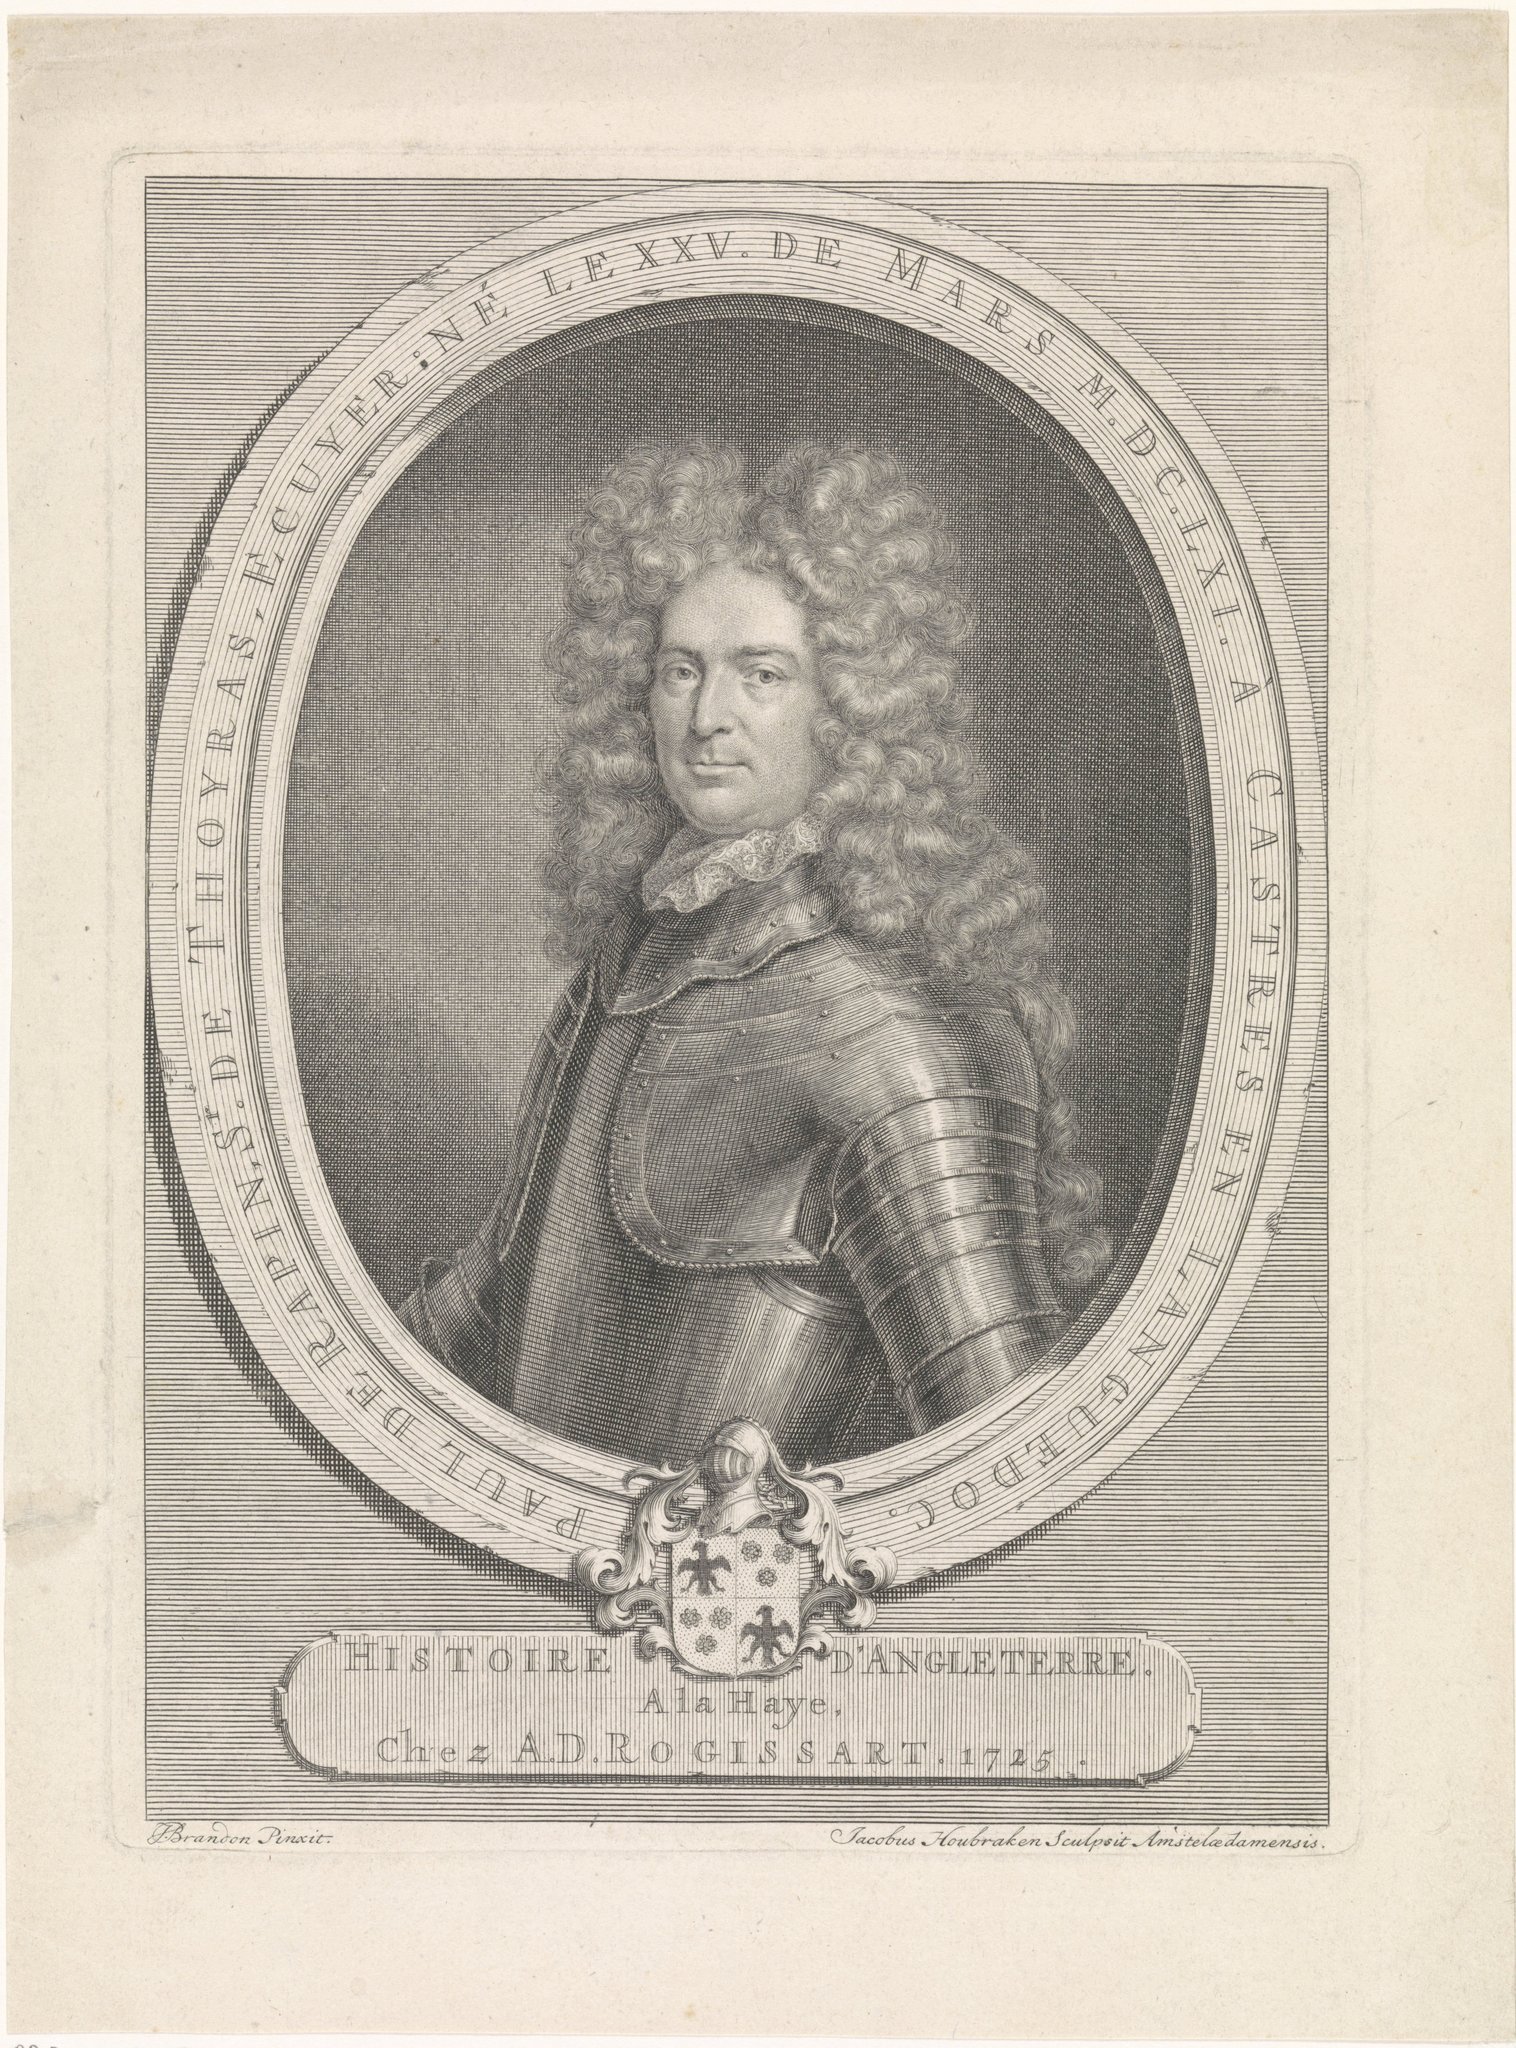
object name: print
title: Paul Rapin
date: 1725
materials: paper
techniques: engraving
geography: the hague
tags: schrijver, paul de rapin de thoyras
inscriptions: collector's mark: Lugt 2228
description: Portret ten halven lijve naar links van Paul de Rapin de Thoyras, gekleed in een harnas, in een ovaal met randschrift in het Frans. Onderaan zijn familiewapen en een cartouche waarop het impressum.